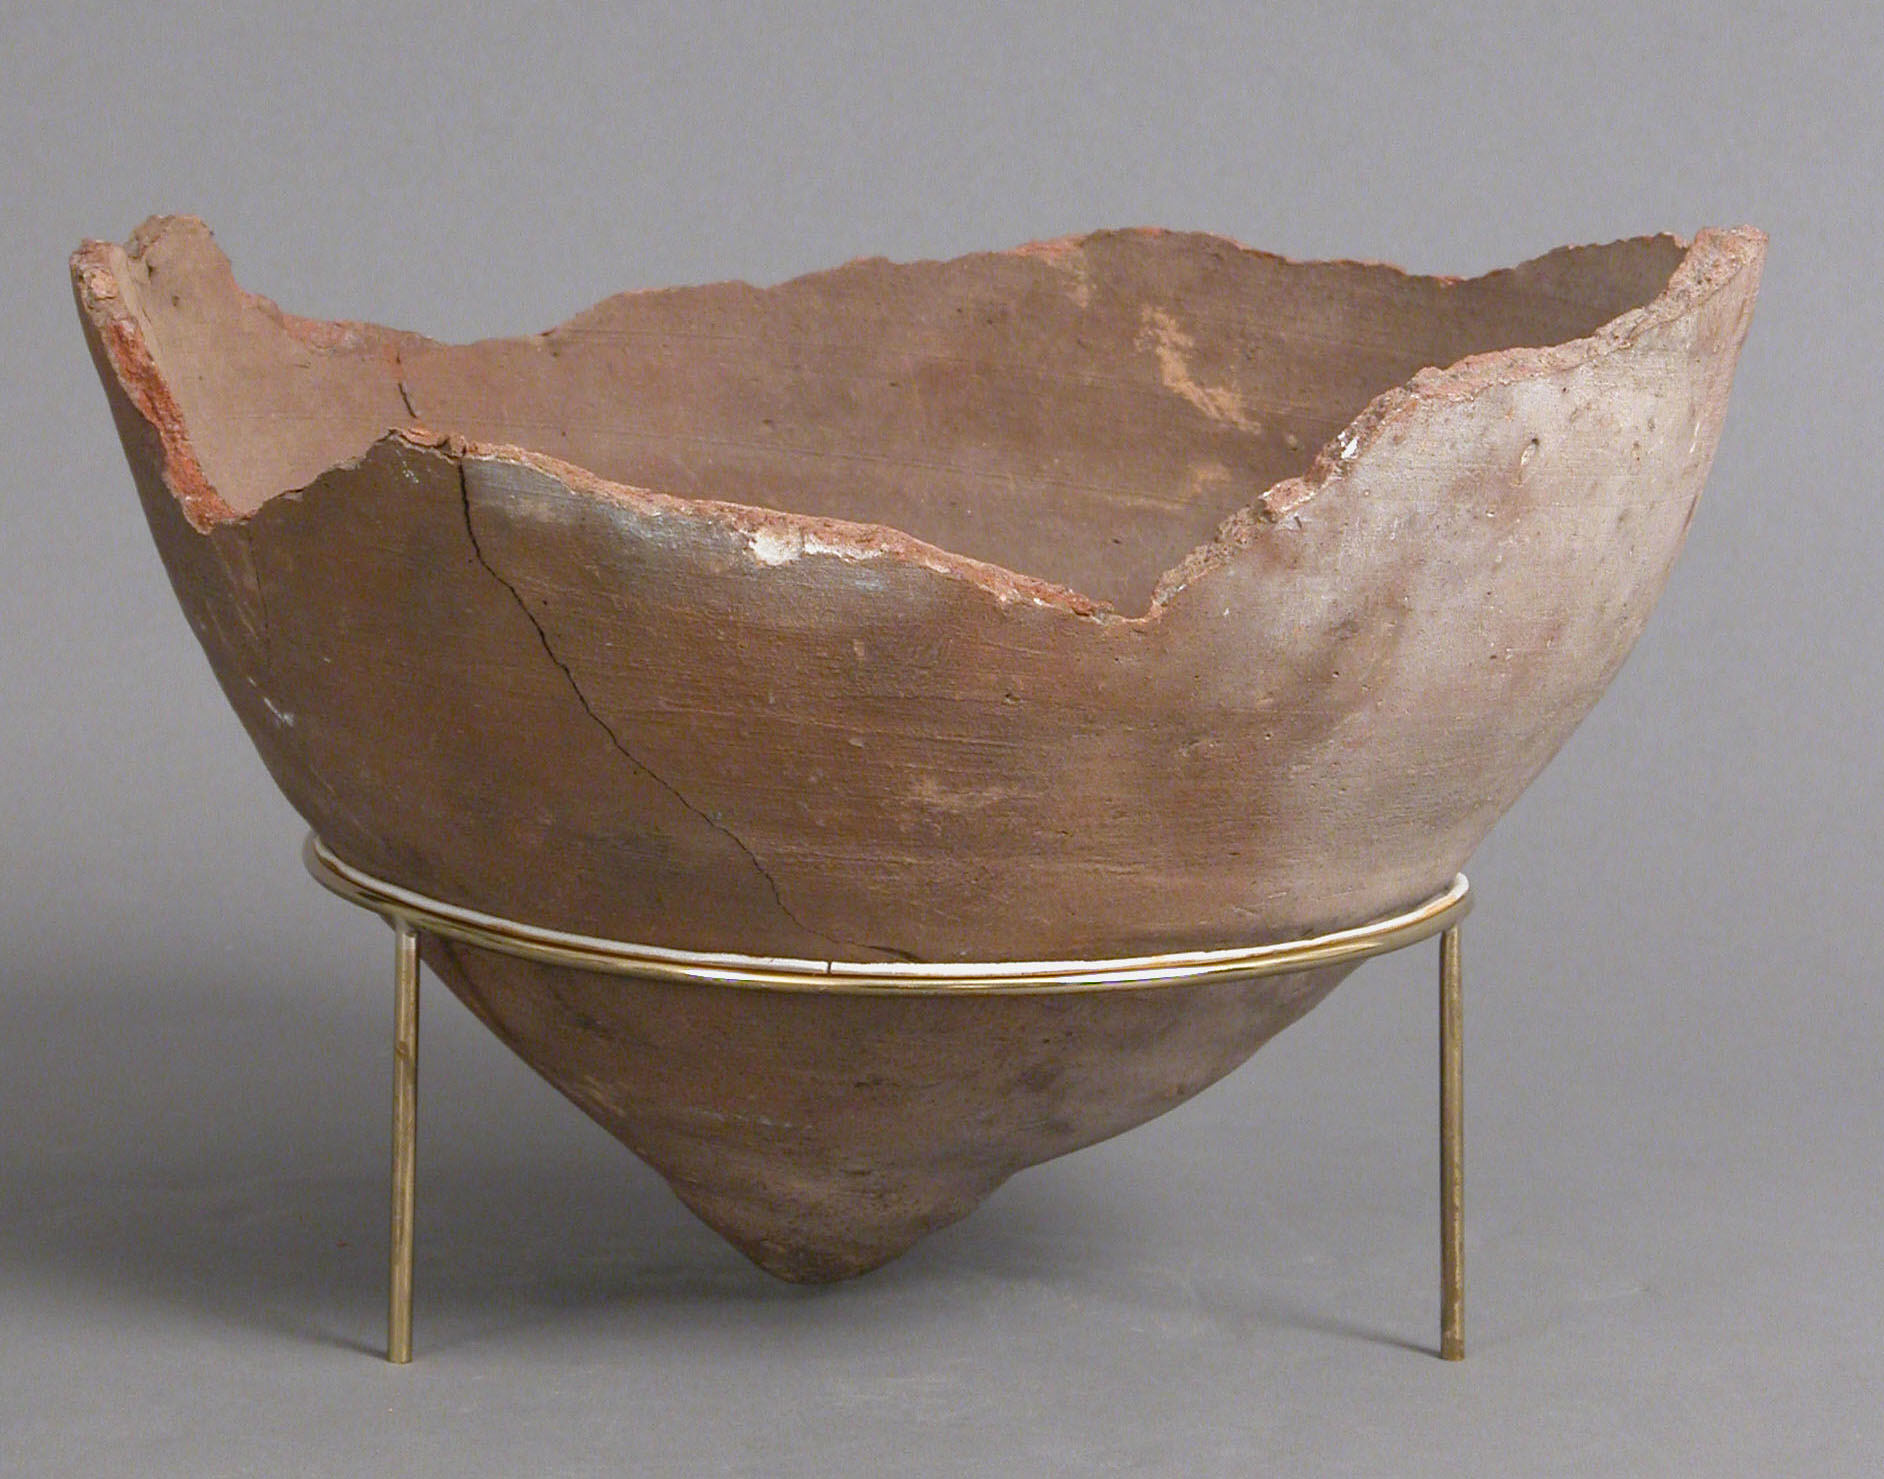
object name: fragment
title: Amphora Fragment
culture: coptic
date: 301-700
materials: earthenware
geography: egypt